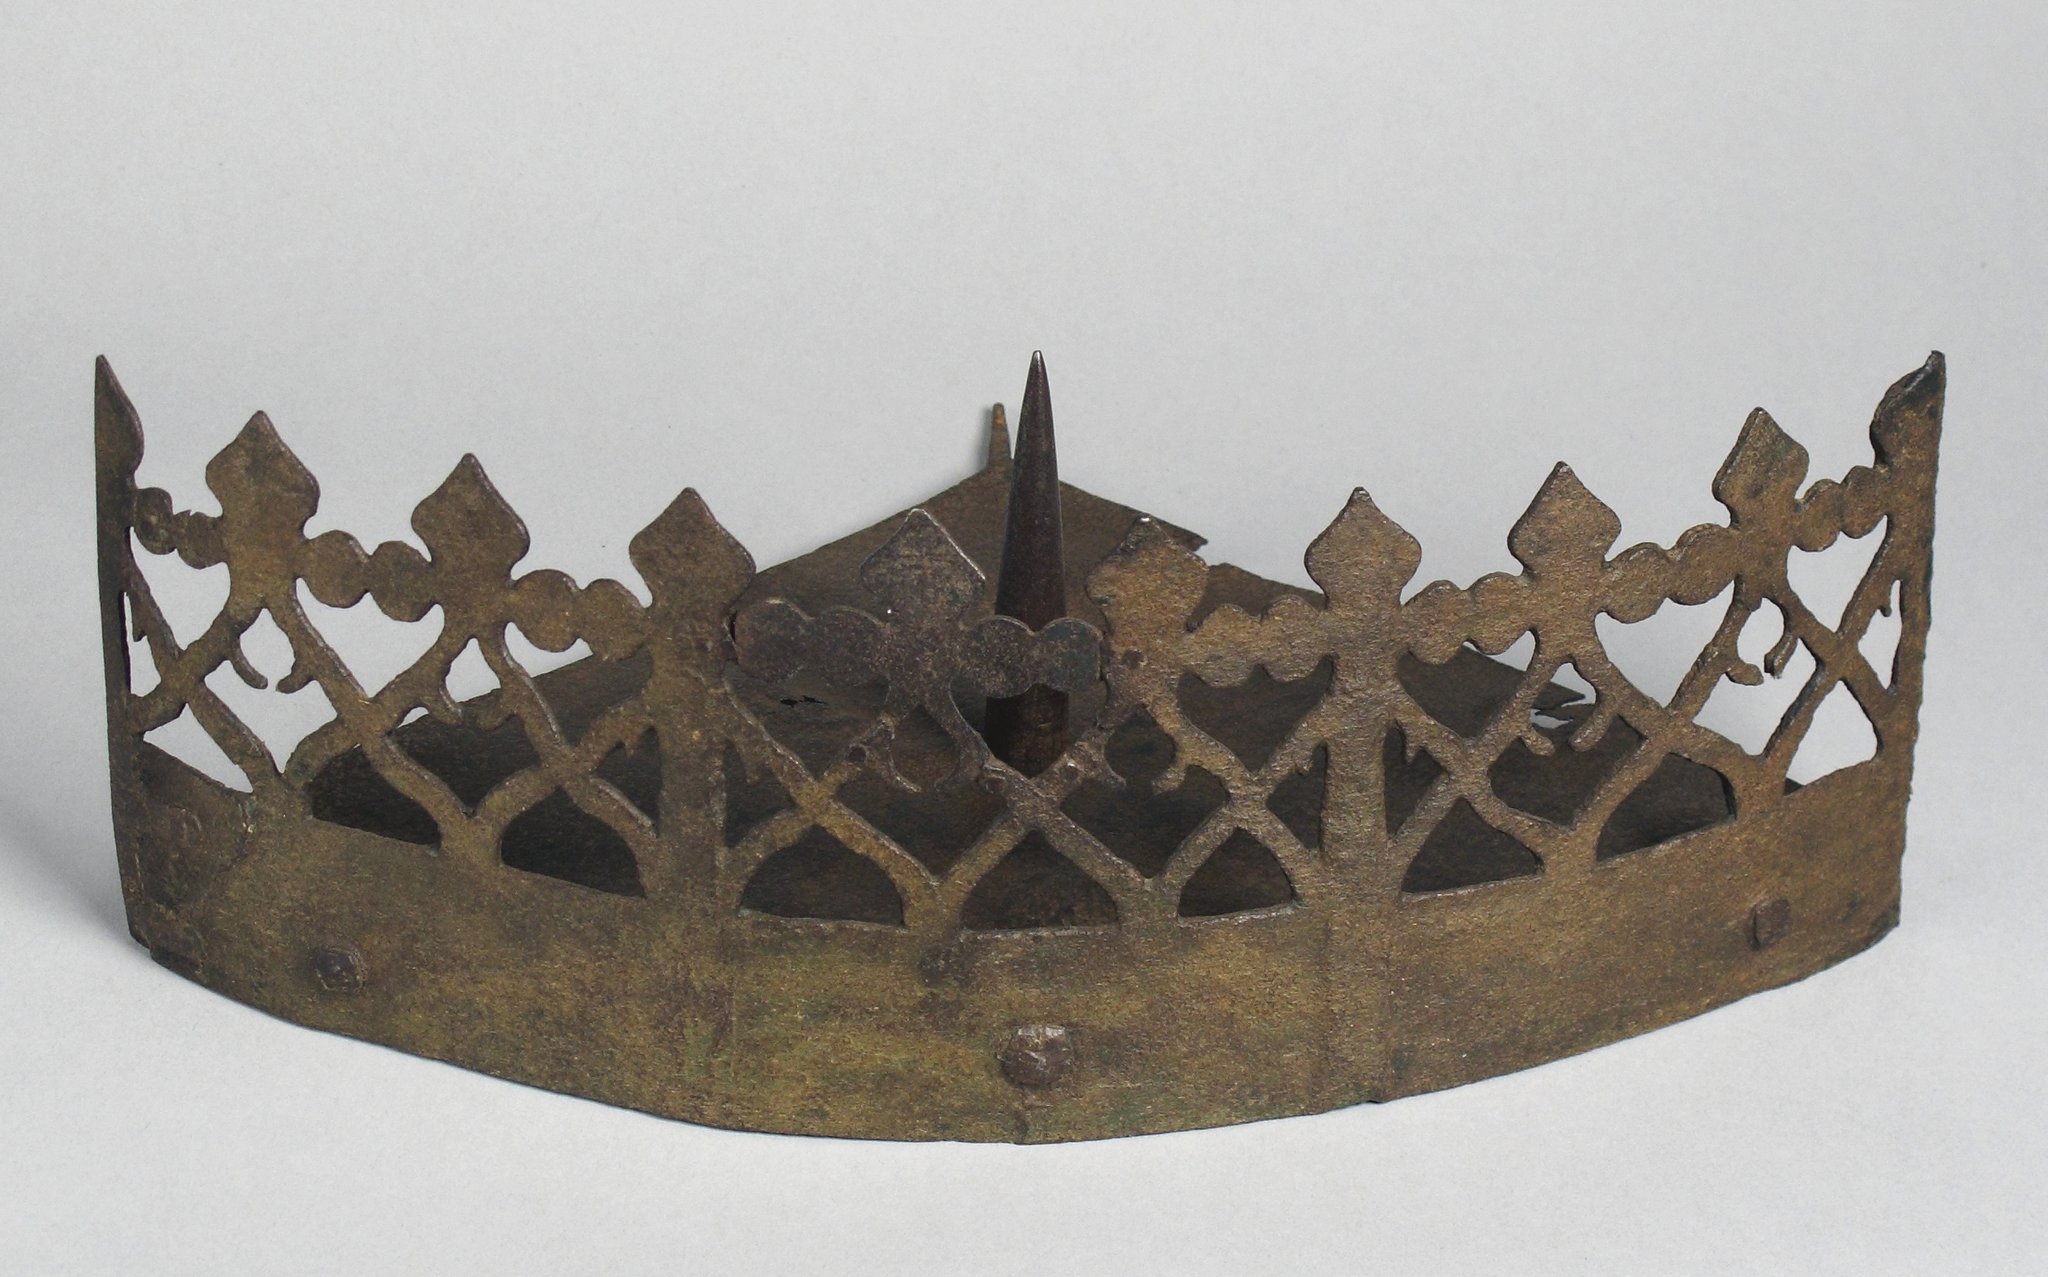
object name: candlestick bracket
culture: european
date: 1401-1600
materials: iron